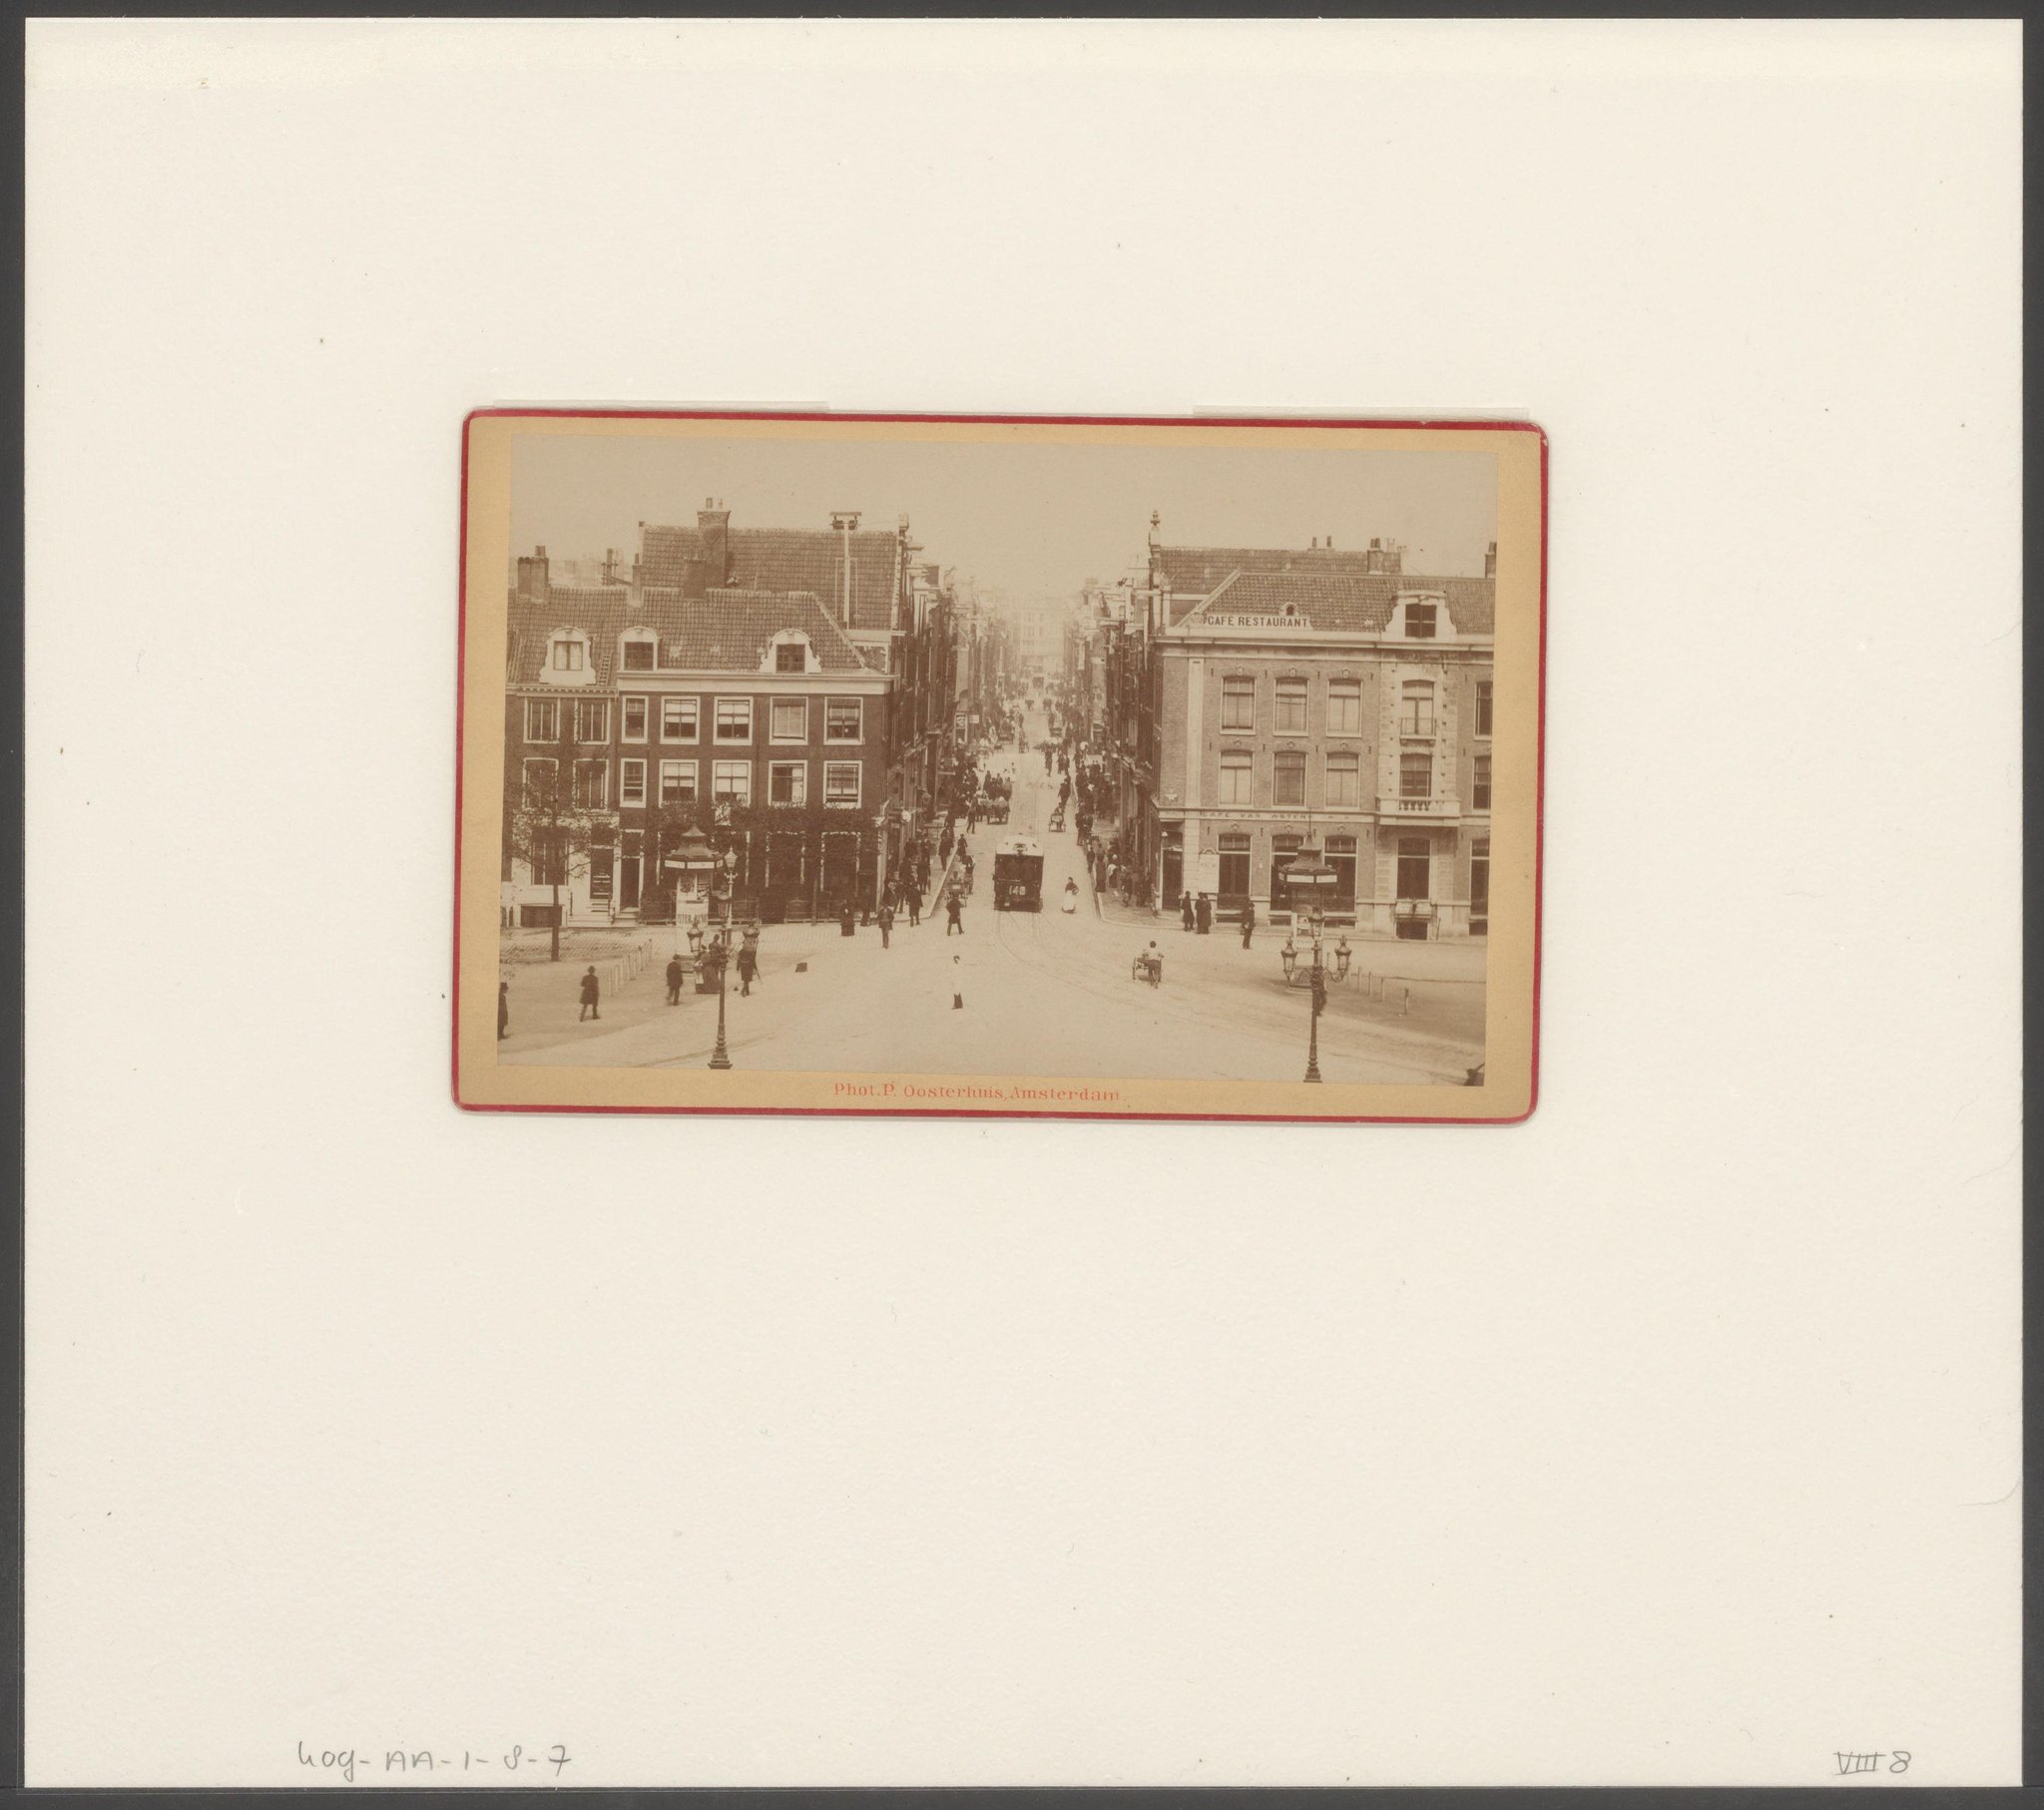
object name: cabinet photograph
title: Gezicht op de Utrechtsestraat vanaf het Frederiksplein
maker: pieter oosterhuis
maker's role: draughtsman, print maker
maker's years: 1816-1885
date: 1826-1885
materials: cardboard, paper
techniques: albumen print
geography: amsterdam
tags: square, place, circus, etc., city-view in general; 'veduta', the usual house or row of houses, street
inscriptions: inscription: ‘Utrechtschestraat / van het / Frederiksplein / gezien. / 5’, collector's mark: ‘8’ Lugt 1641b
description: Onderwerpsrubriek binnen de Atlas Amsterdam: Egelantiersdwarsstraat, Egelantiersgracht, Elandsgracht, Engelschesteeg, Foeliedwarsstraat, Frederiksplein, Funen.